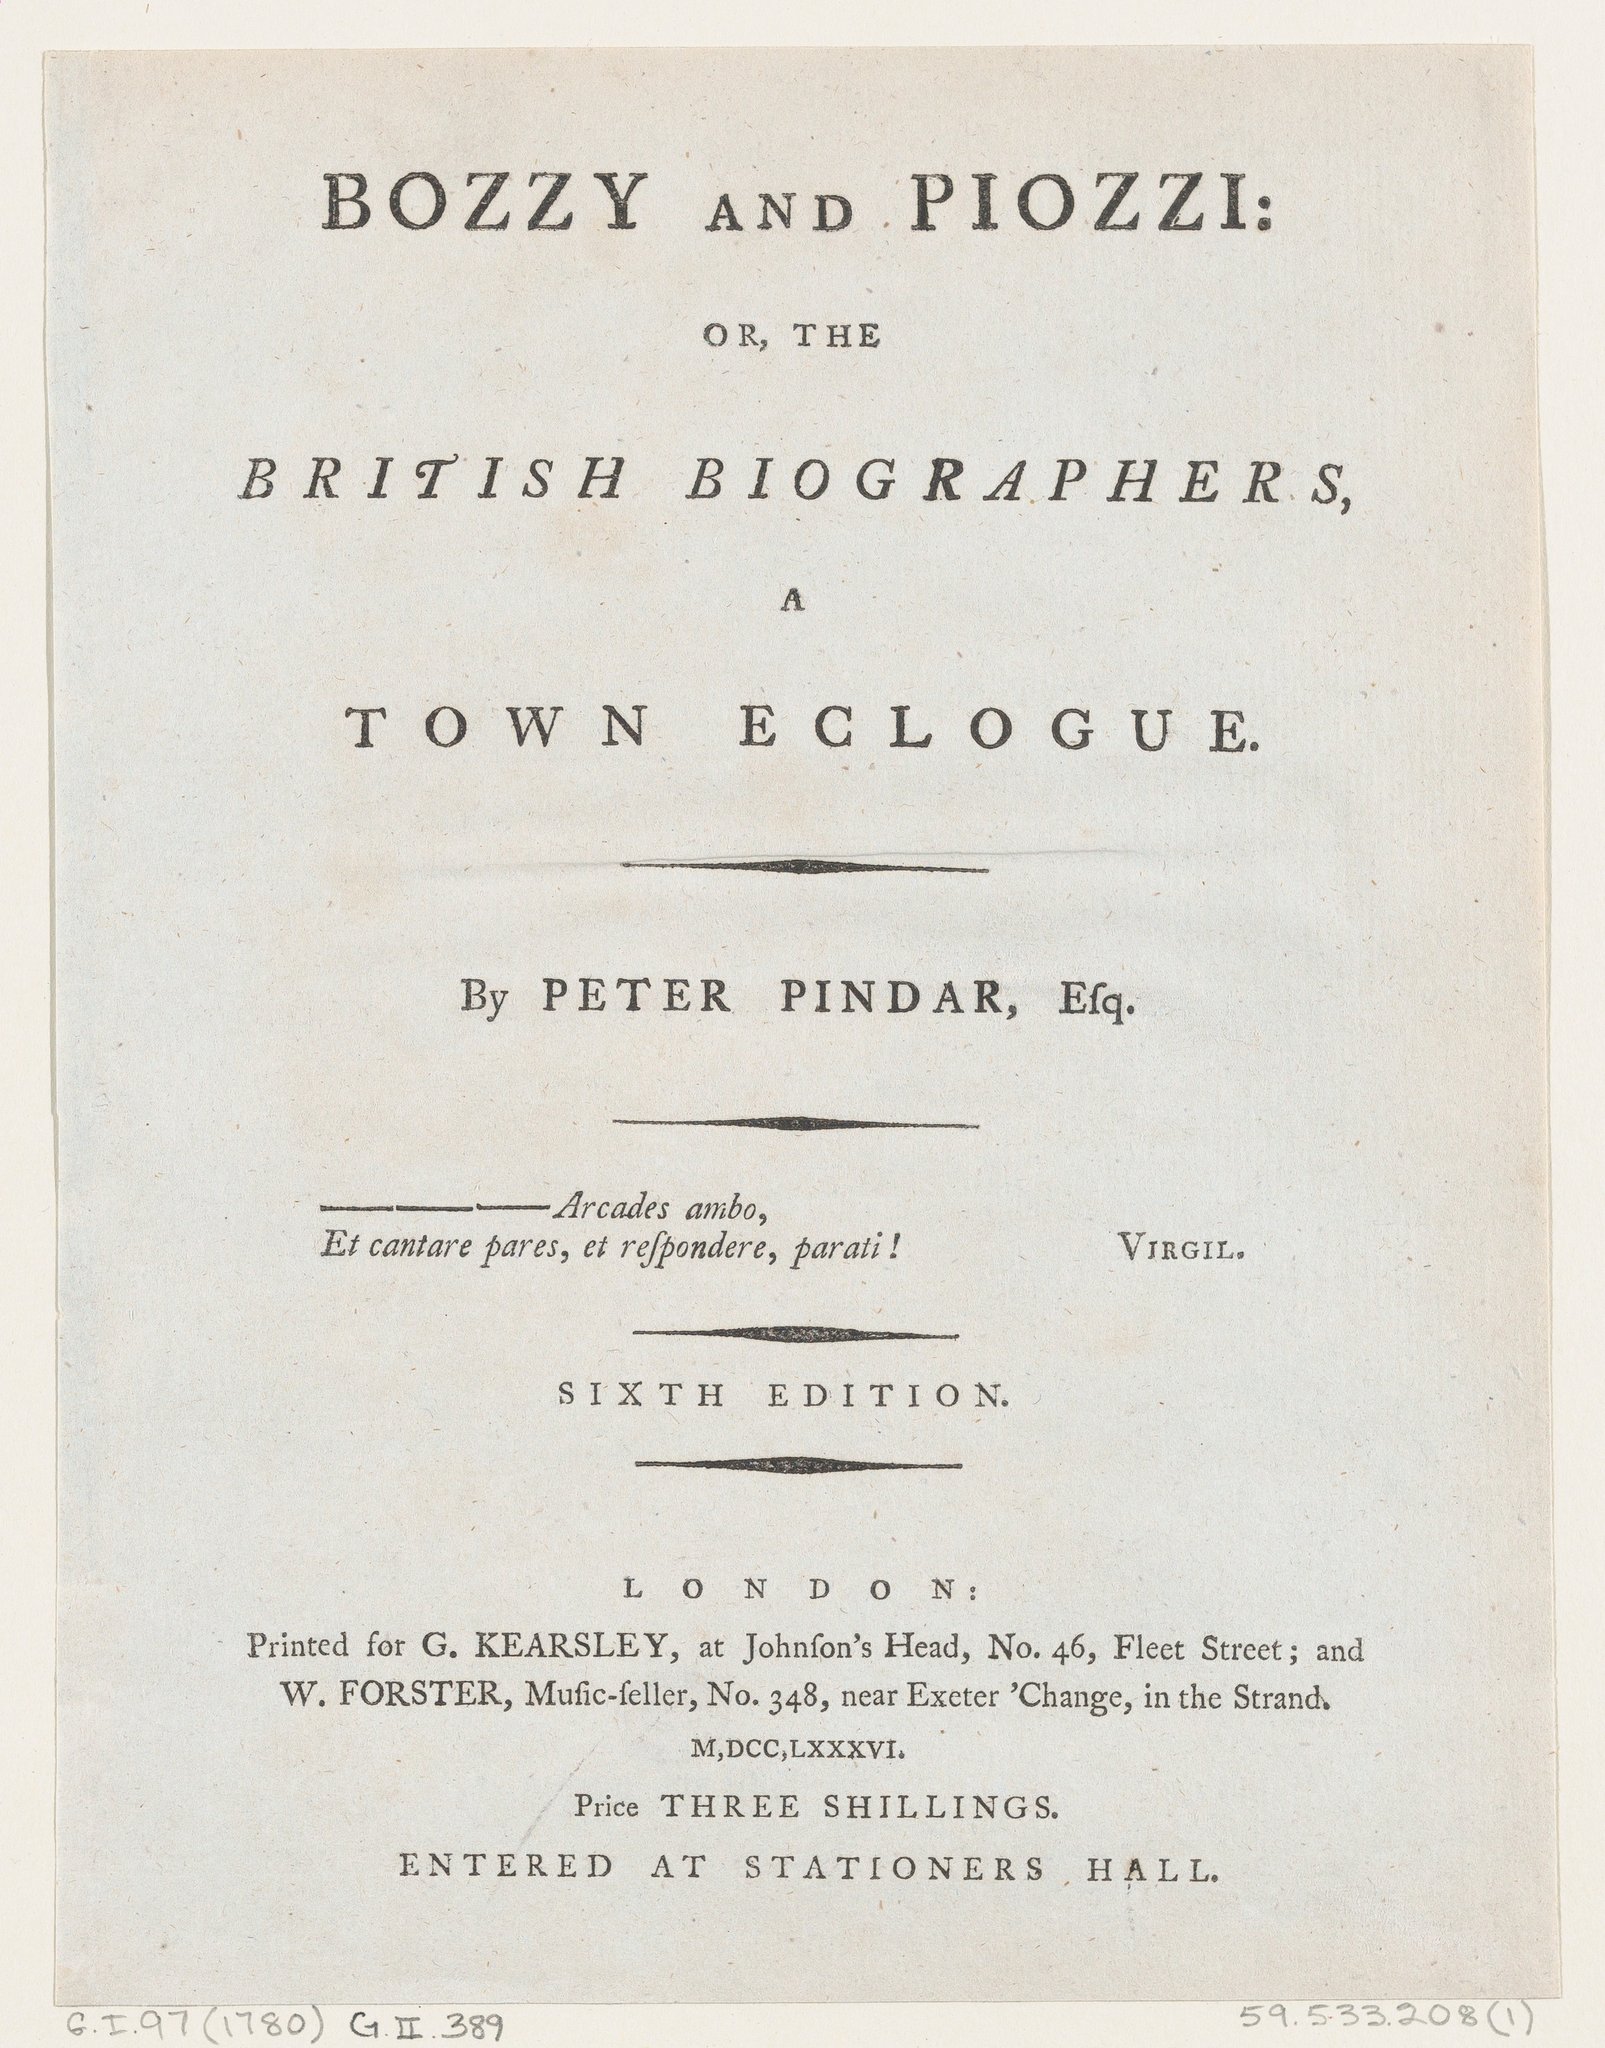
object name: print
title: Title Page, from Bozzy and Piozzi by Peter Pindar, Esq.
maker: george kearsley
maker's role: publisher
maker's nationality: british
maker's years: 1753-1790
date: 1787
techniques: engraving